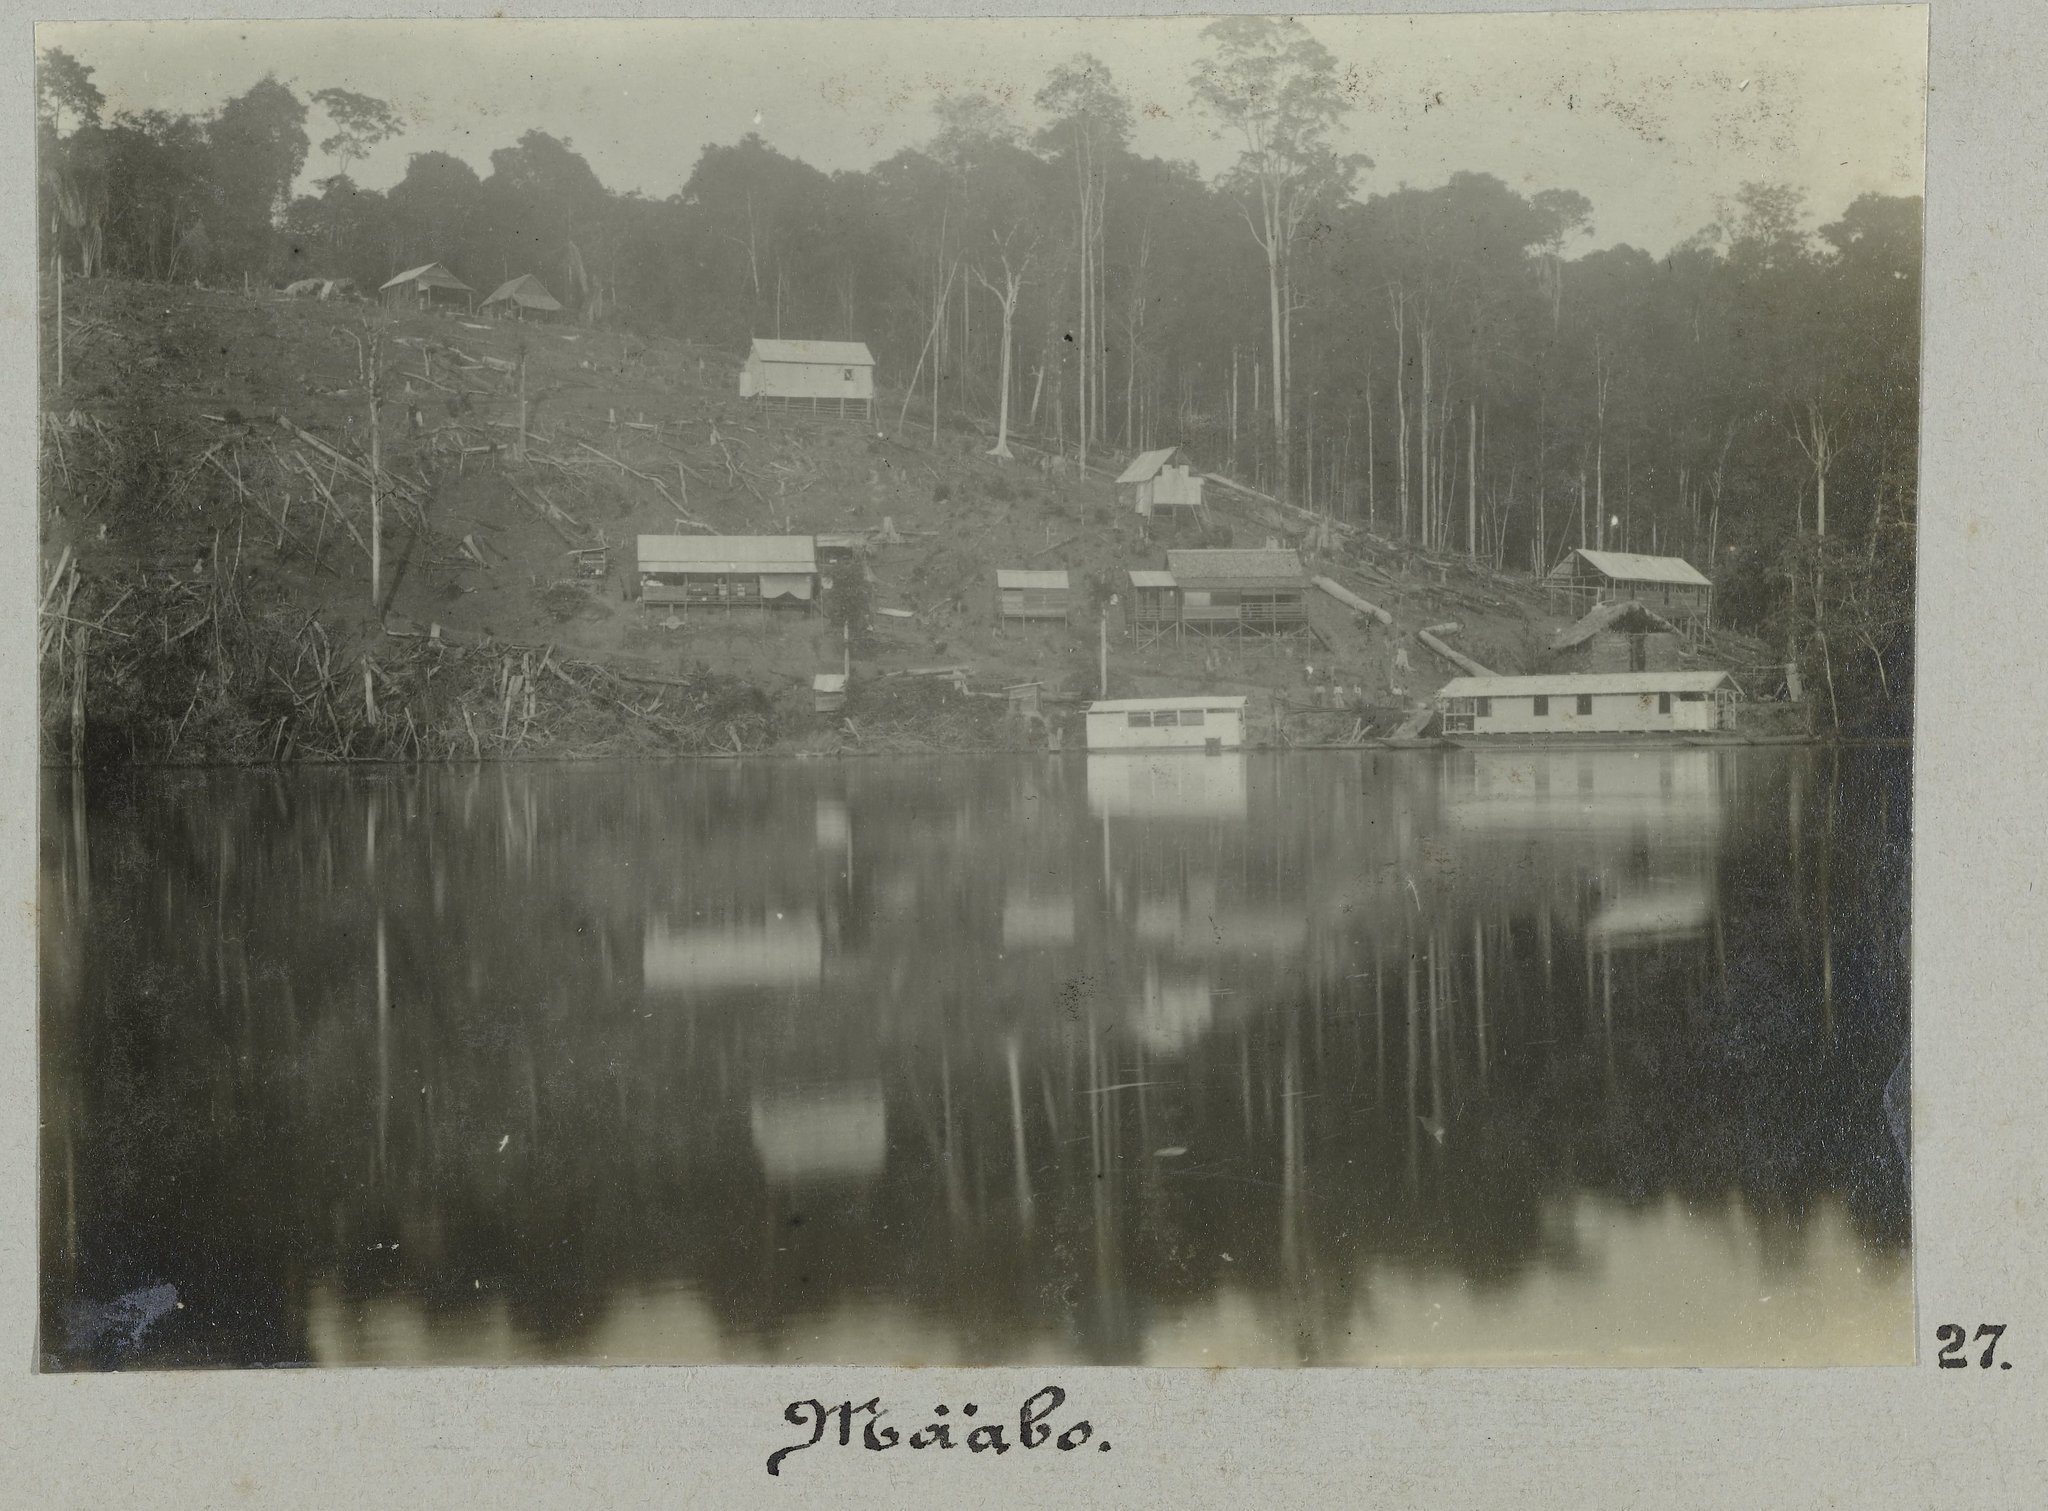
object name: photograph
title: Mäabo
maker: hendrik doijer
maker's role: engineer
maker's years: 1863-1925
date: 1903-1910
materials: photographic support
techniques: gelatin silver print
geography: suriname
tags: suriname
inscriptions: inscription: ‘27. / Mäabo.’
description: Huizen op een heuvel aan het water, bij de Maäbo Heuvel, voor de afspuiting ten behoeve van de aanleg van de Lawaspoorweg (1903-1912). Onderdeel van het fotoalbum Souvenir de Voyage (deel 1), over het leven van de familie Doijer in en rond de plantage Ma Retraite in Suriname in de jaren 1903-1910.